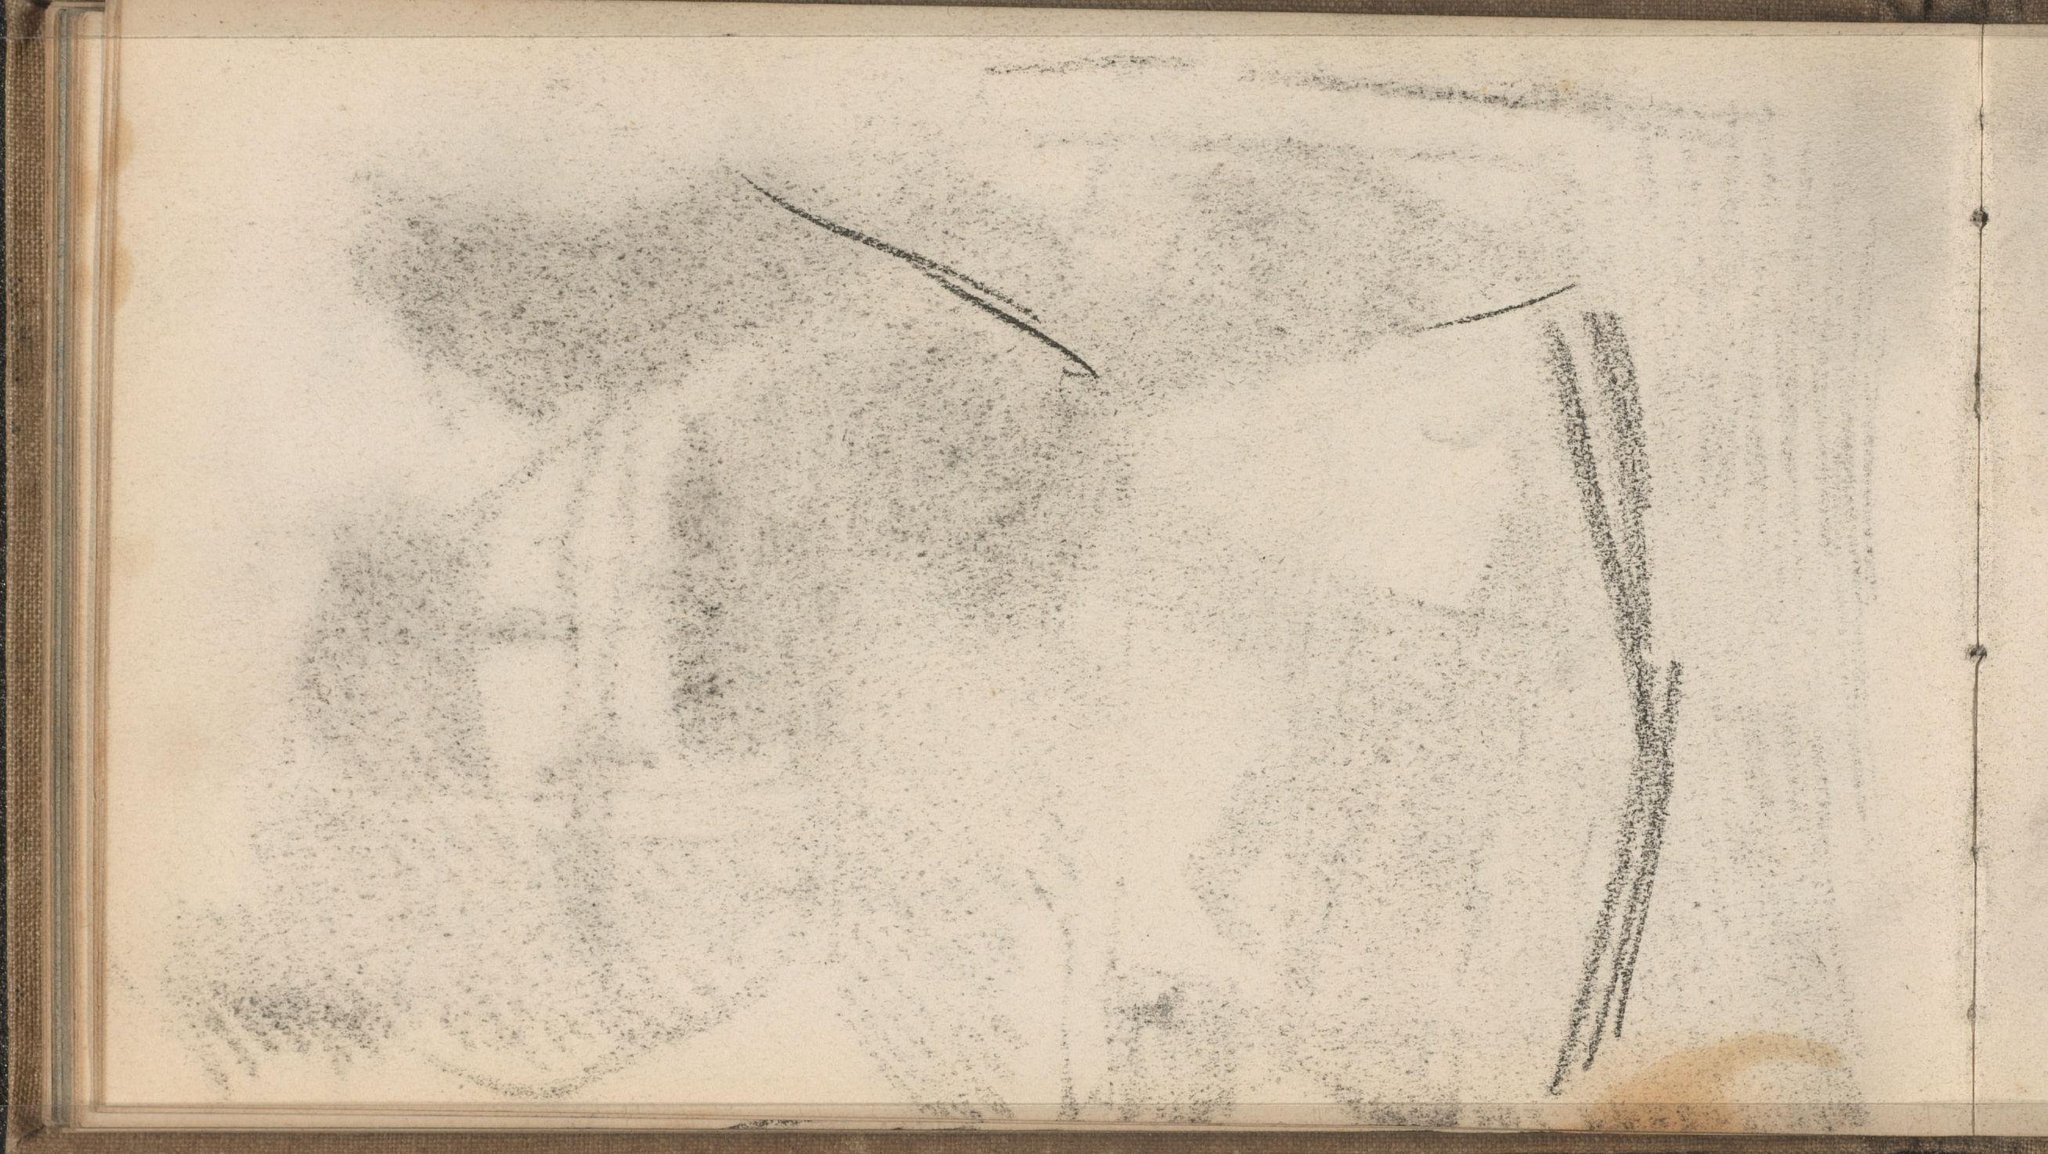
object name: sketchbook leaf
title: Studie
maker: george hendrik breitner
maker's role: draughtsman, painter, print maker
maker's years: 1857-1923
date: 1883-1885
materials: chalk, paper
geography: drenthe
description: Pagina 85 uit een schetsboek met 48 bladen.